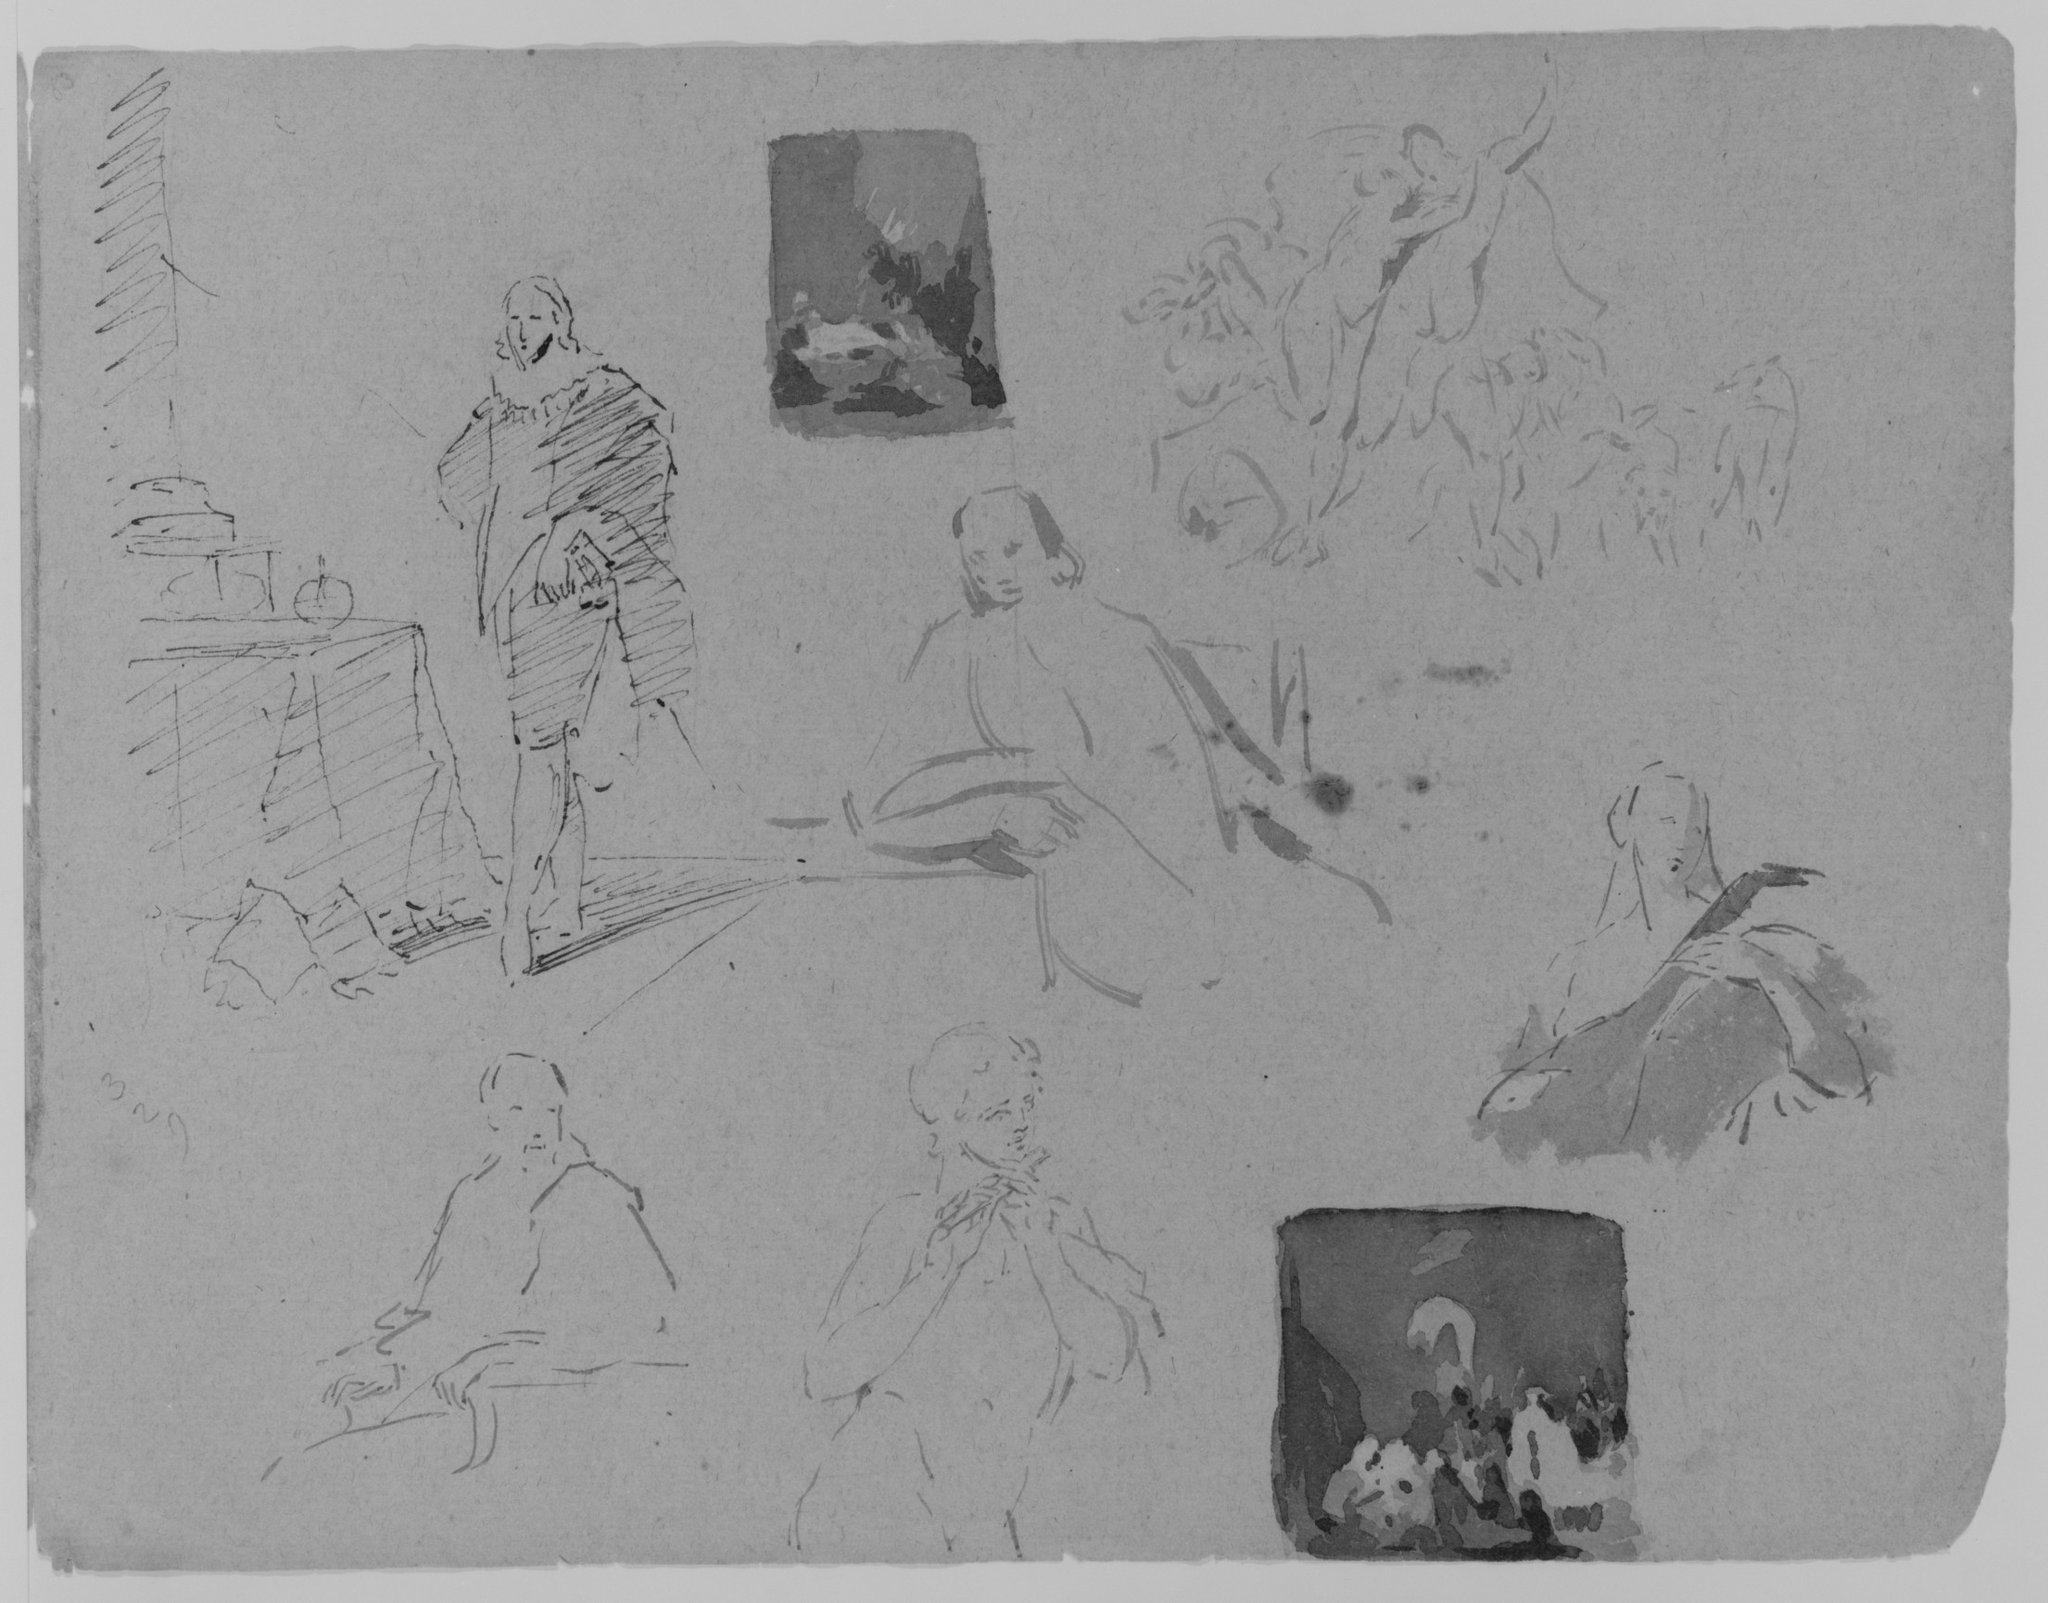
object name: drawing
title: (From Sketchbook)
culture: american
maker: thomas sully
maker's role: artist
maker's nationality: american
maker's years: 1783-1872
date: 1810-1820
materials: ink, paper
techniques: wash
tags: men,flutes,lutes